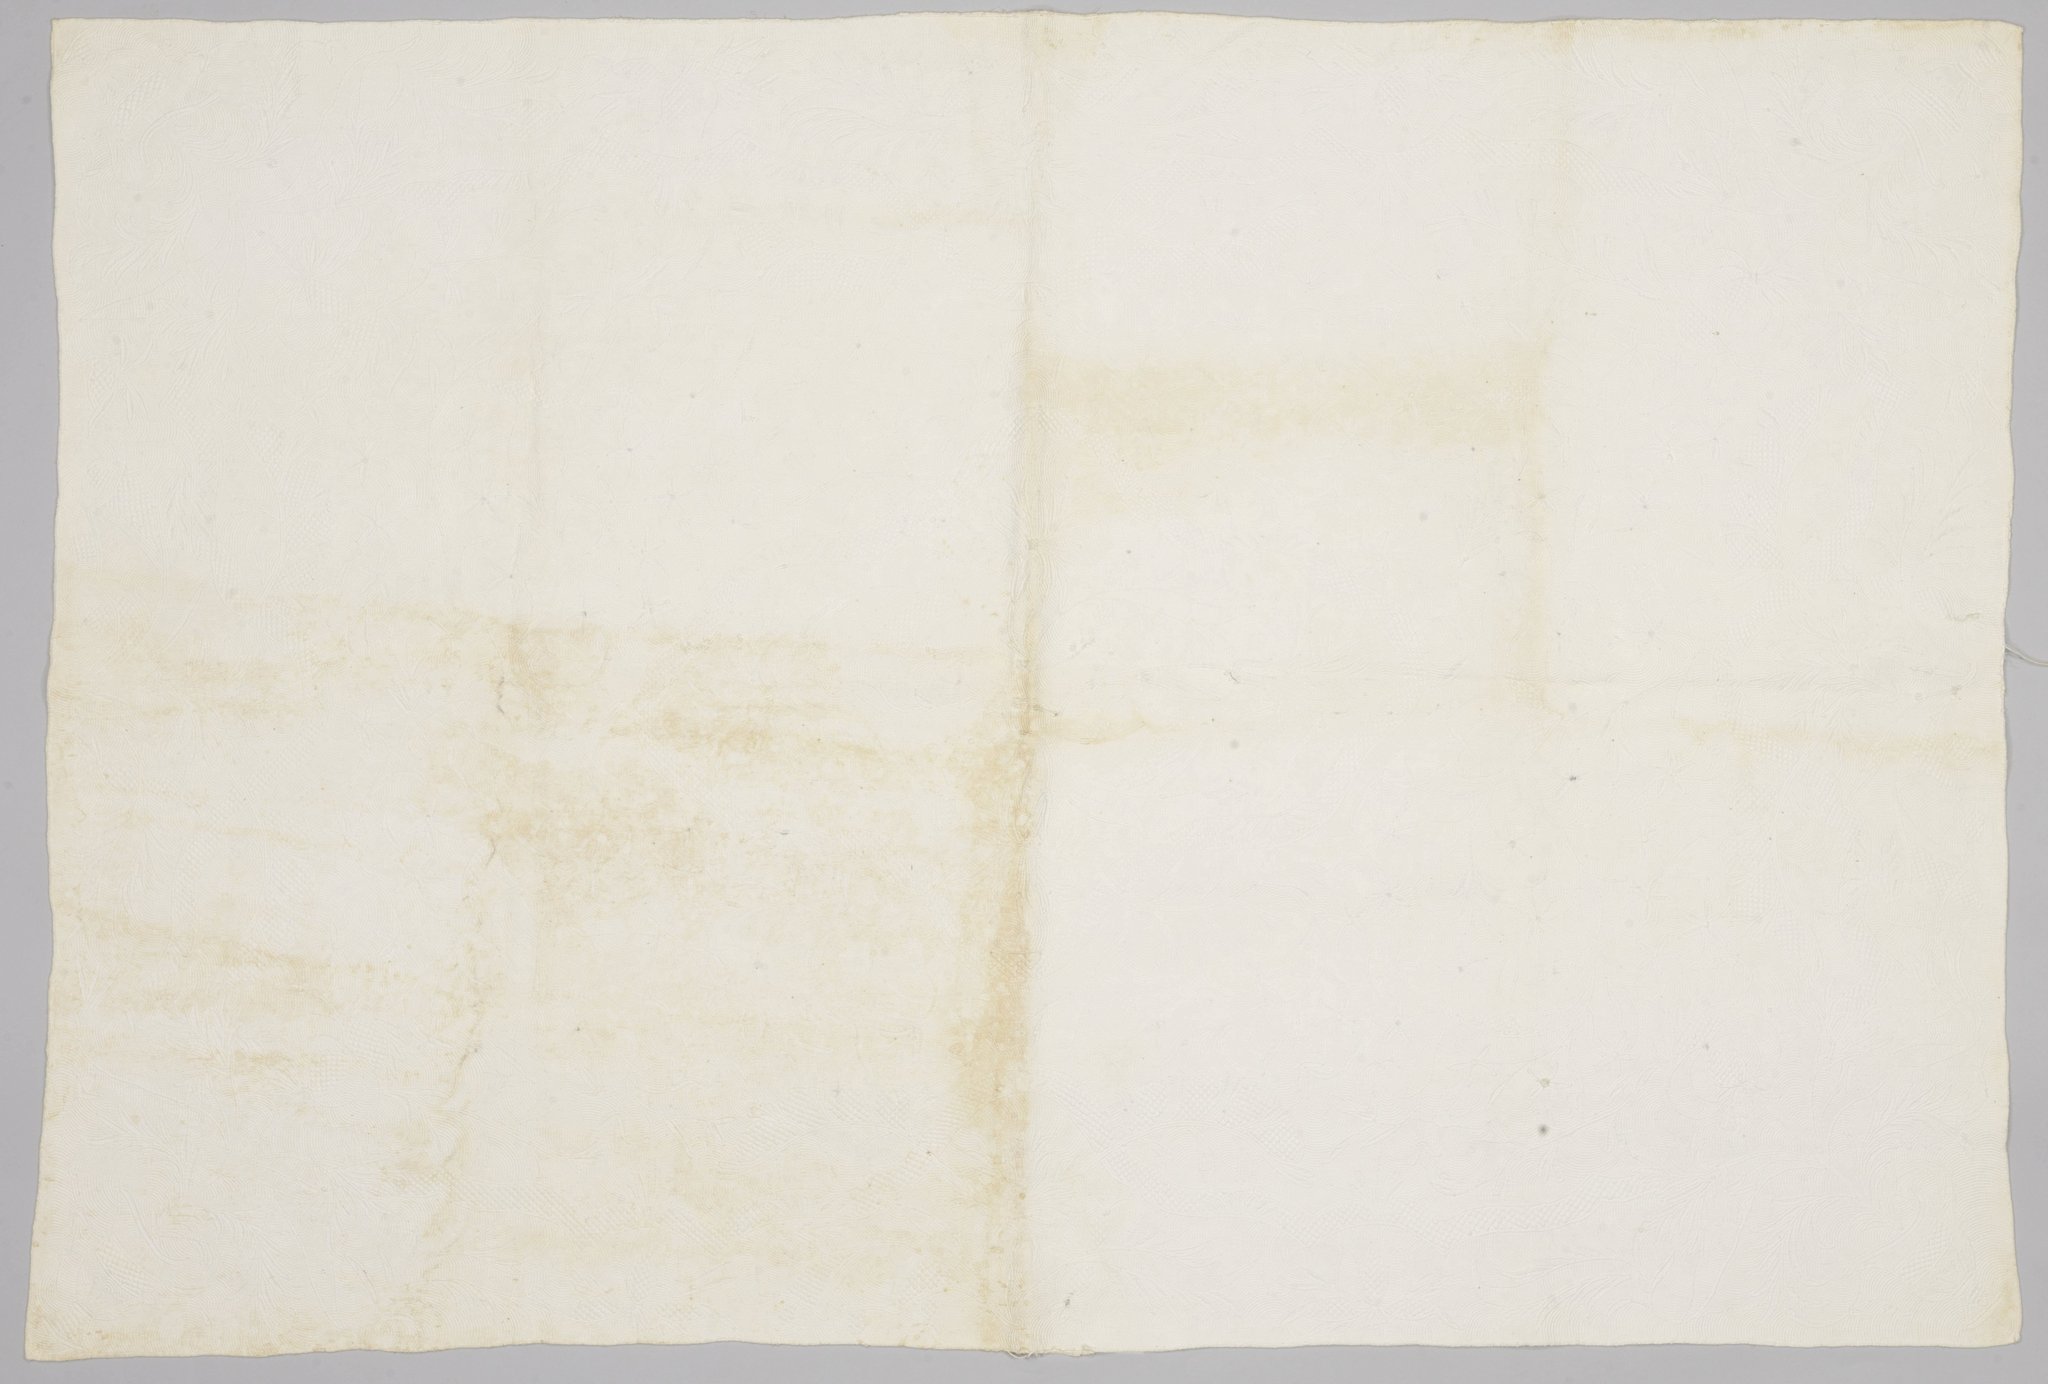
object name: bed covering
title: Sprei met Zaans stikwerk.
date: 1740-1760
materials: linen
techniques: embroidered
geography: netherlands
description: Sprei, z.g. Zaans stikwerk. In het midden een geschulpt medaillon met vier anjers. Rand van bandwerk met anjers en in elke hoek een lampetkan met granaatappel.